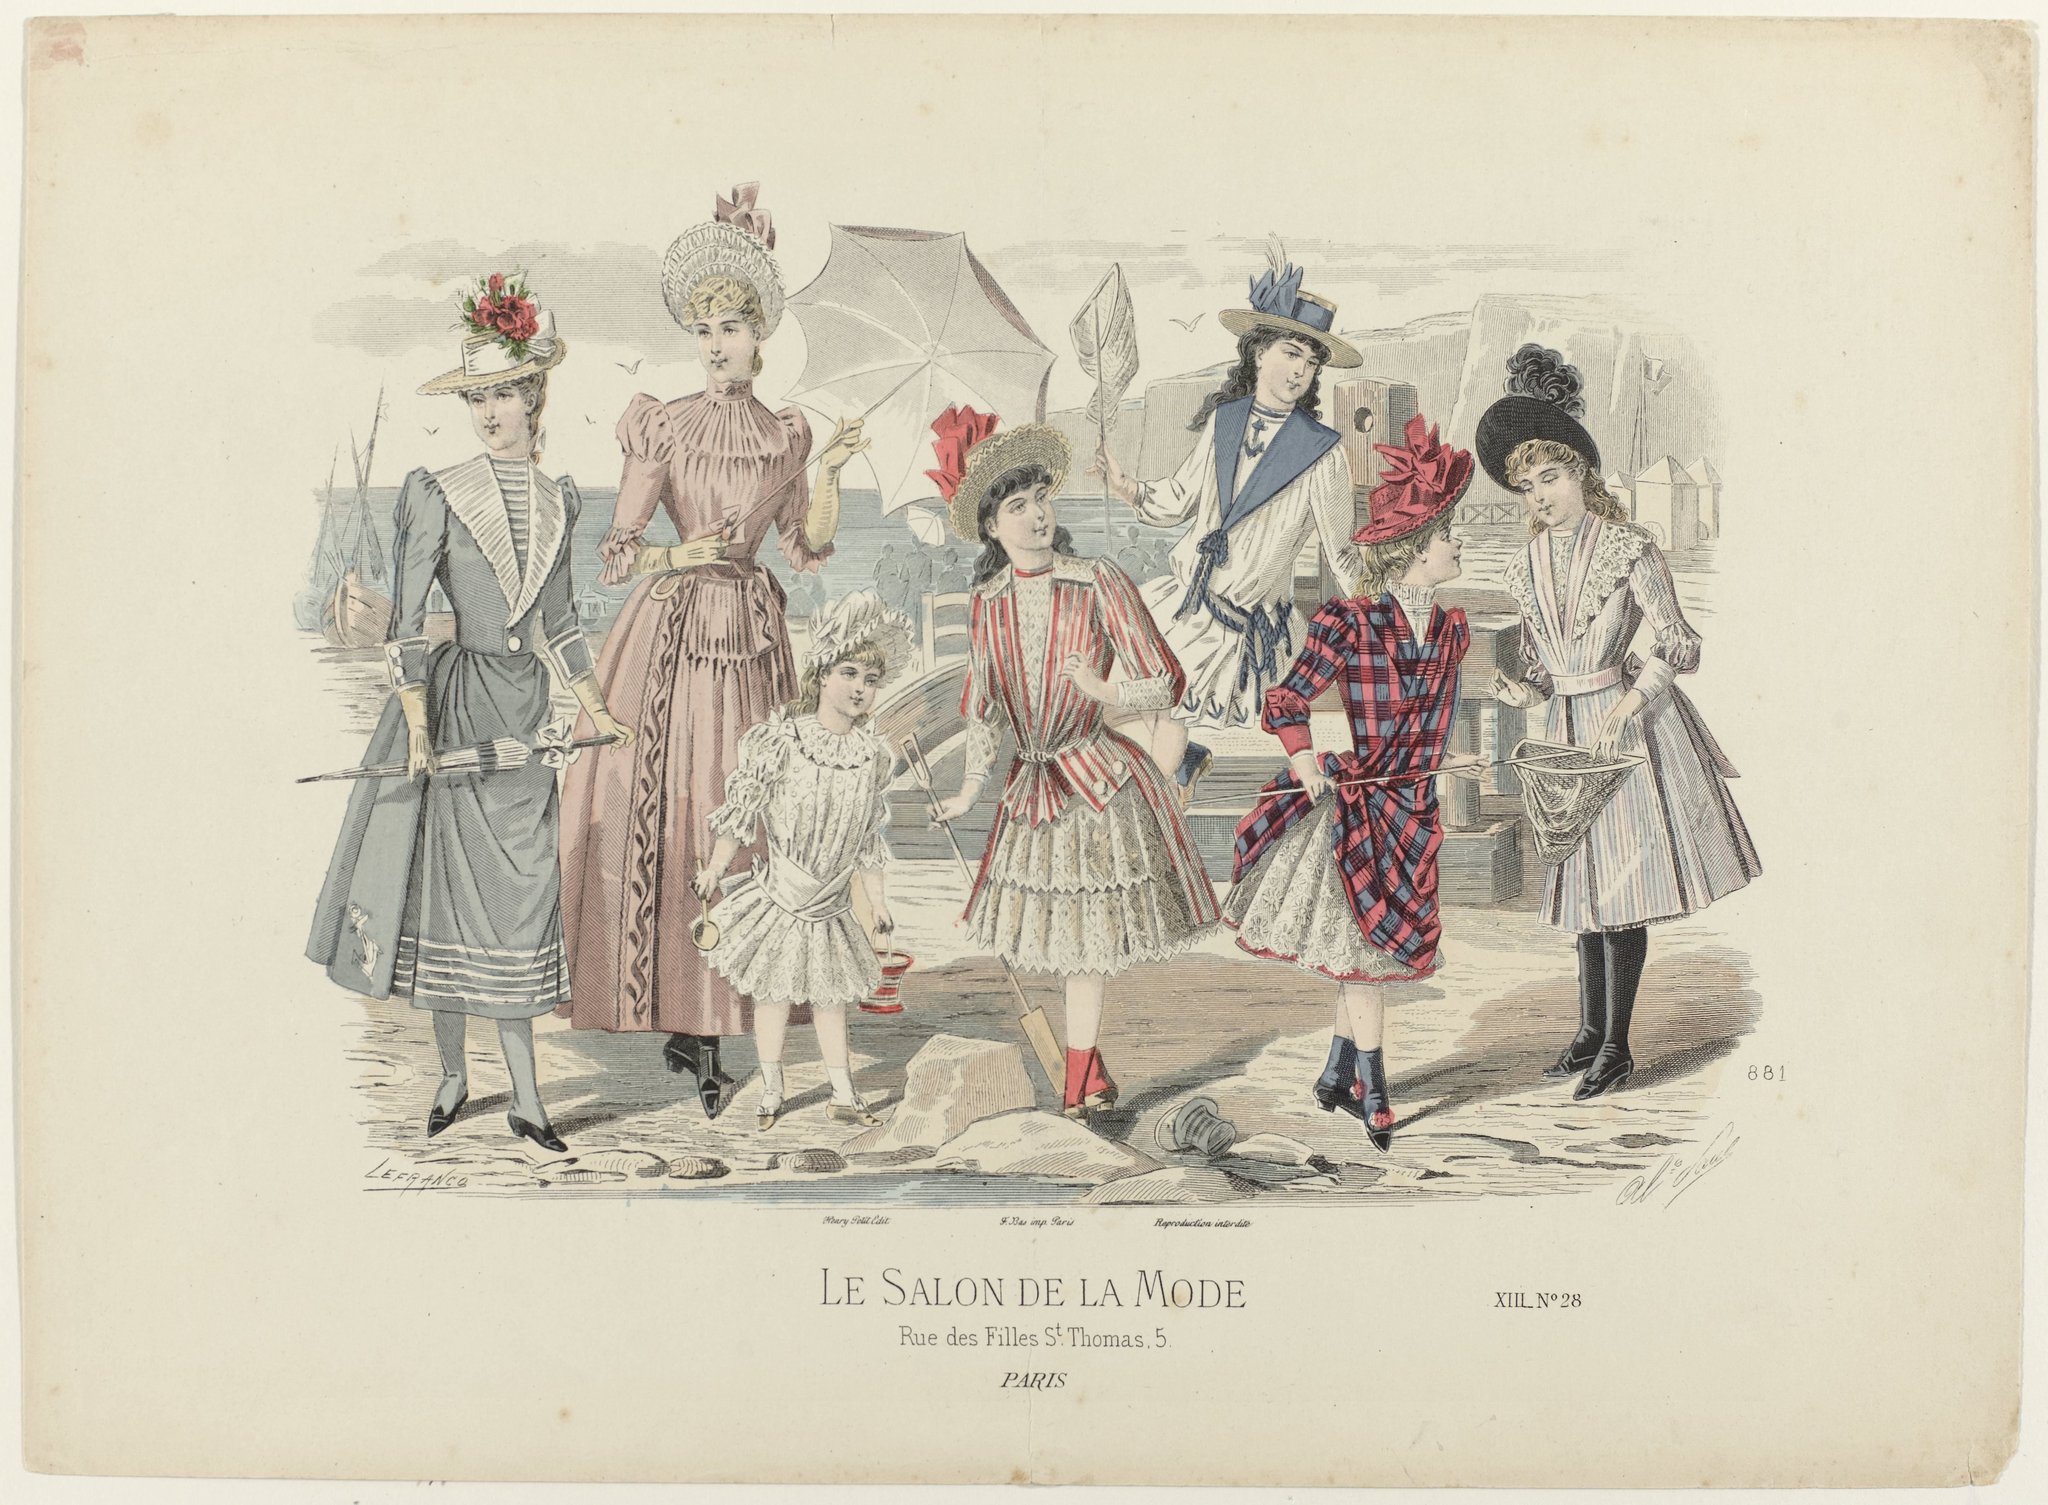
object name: fashion print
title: Le Salon de la Mode, 1889, XIIL No. 881, Pl. 28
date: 1889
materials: paper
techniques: engraving, hand coloring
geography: paris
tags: recreation in the dunes, varia (playing with toys), head-gear: boater (+ girls' clothes), fashion plates, head-gear: hat (+ women's clothes), dress, gown (+ women's clothes), parasol, sunshade (+ women's clothes), dress, gown (+ girls' clothes)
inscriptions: title: ‘Le Salon de la Mode’, address: ‘Rue des Filles St Thomas, 5 / PARIS’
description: Zeven jonge vrouwen van verschillende leeftijden in japonnen voor op het strand. Parasol, schepnet, emmer en schep in de handen. Op de achtergrond de zee, boten en enkele strandhuisjes. Prent uit het modetijdschrift Le Salon de la Mode (1876-1914).